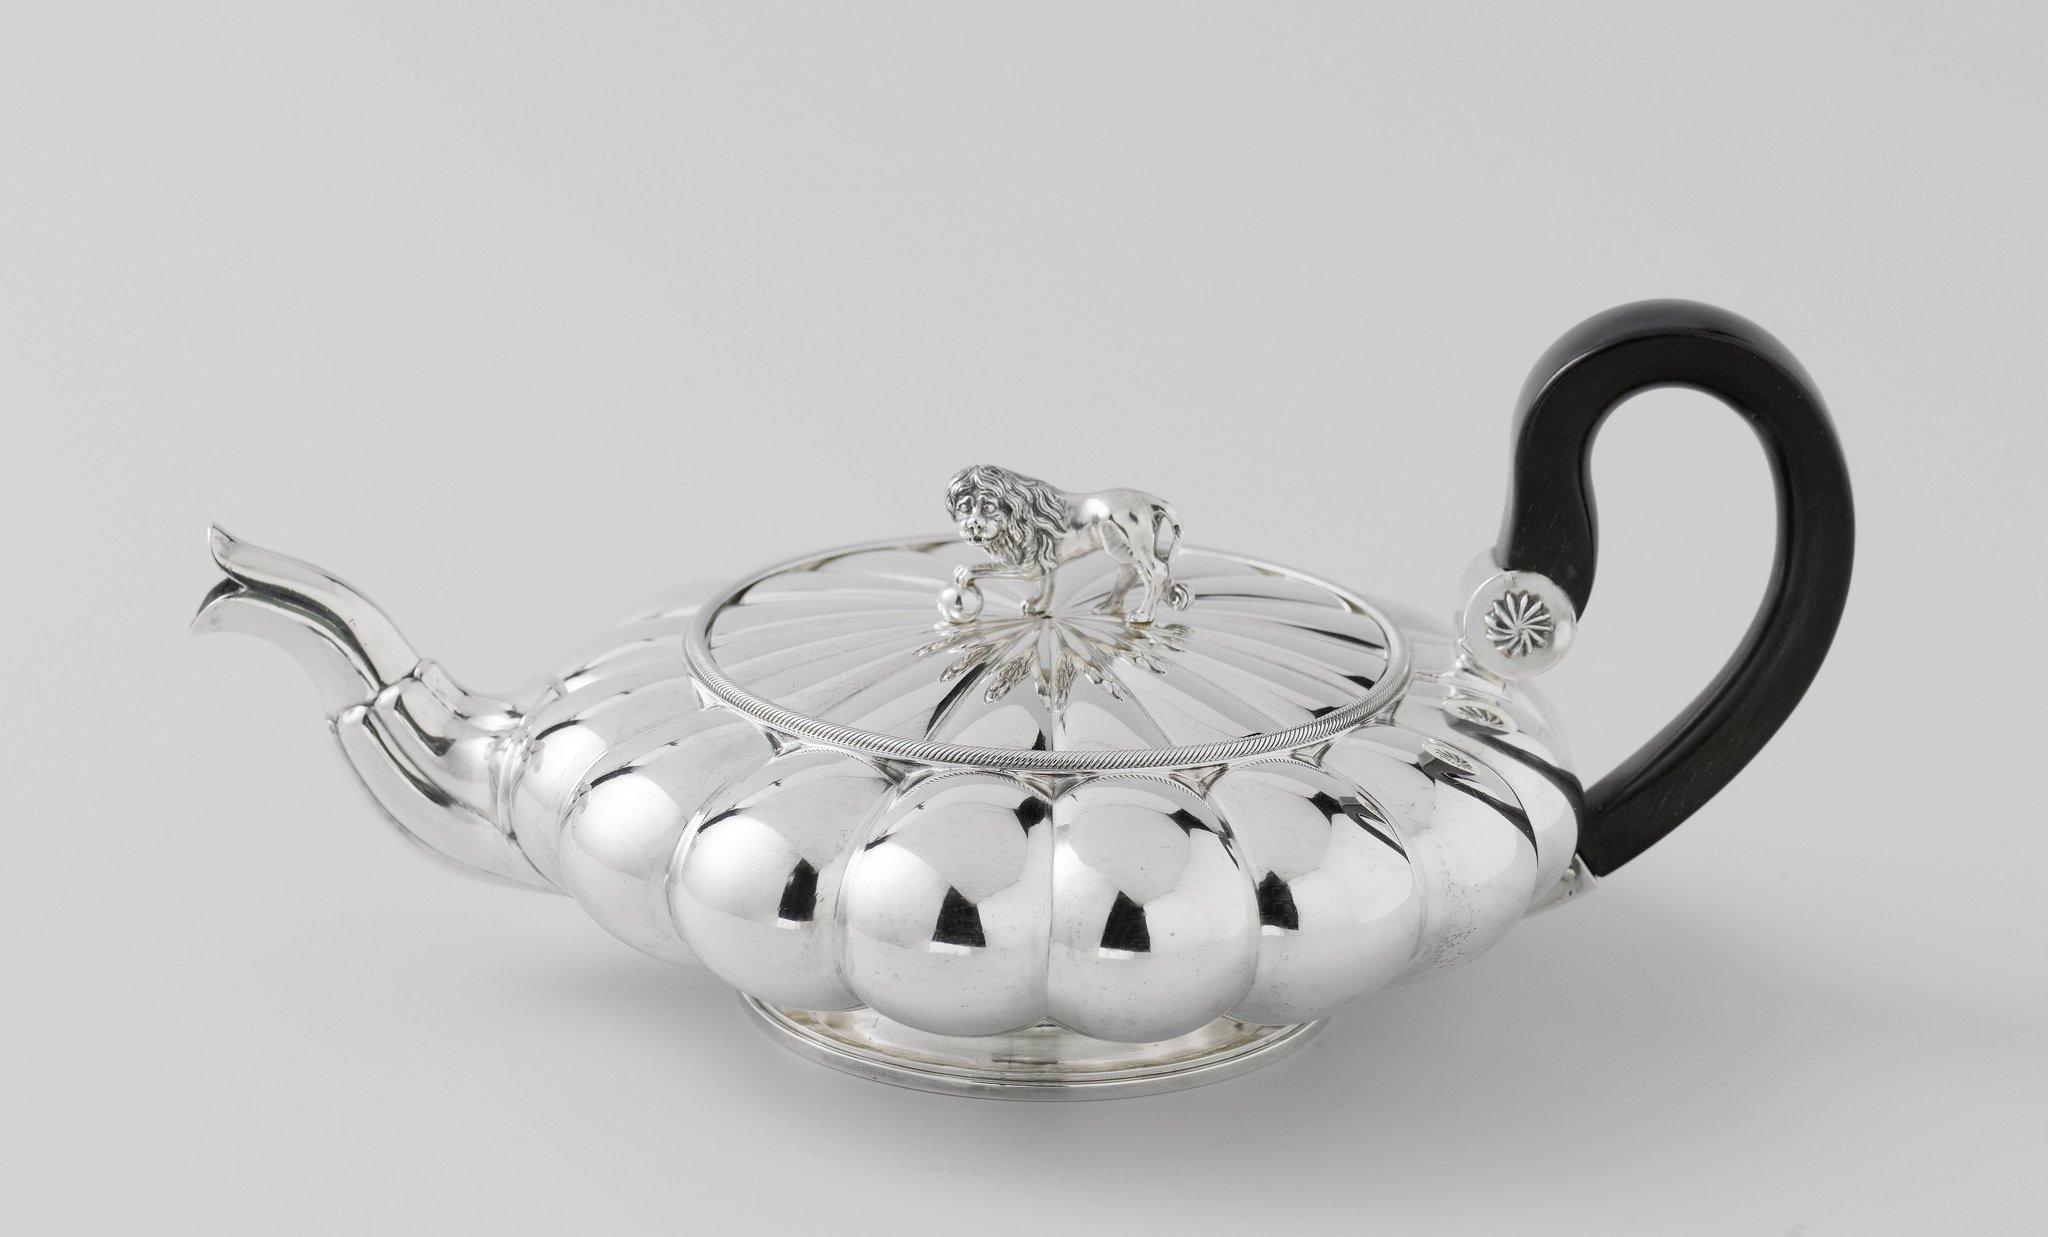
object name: teapot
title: Three-piece tea service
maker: theodorus gerardus bentvelt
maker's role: silversmith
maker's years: 1782-1853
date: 1833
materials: wood, silver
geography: amsterdam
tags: beasts of prey, predatory animals: lion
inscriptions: mark: ‘Minervakop met A’, alloy mark: ‘leeuw 1ste gehalte’, date letter: ‘Y’, maker's mark: ‘TGB boven kruis in rechthoek’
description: Theepot van zilver, rond afgeplat van vorm en geheel versierd met godrons. Het deksel heeft een "knop" in de vorm van een leeuw. Het oor is van ebbenhout. De theepot is onderdeel van een theeservies bestaande uit theepot, melkkan en suikerpot.